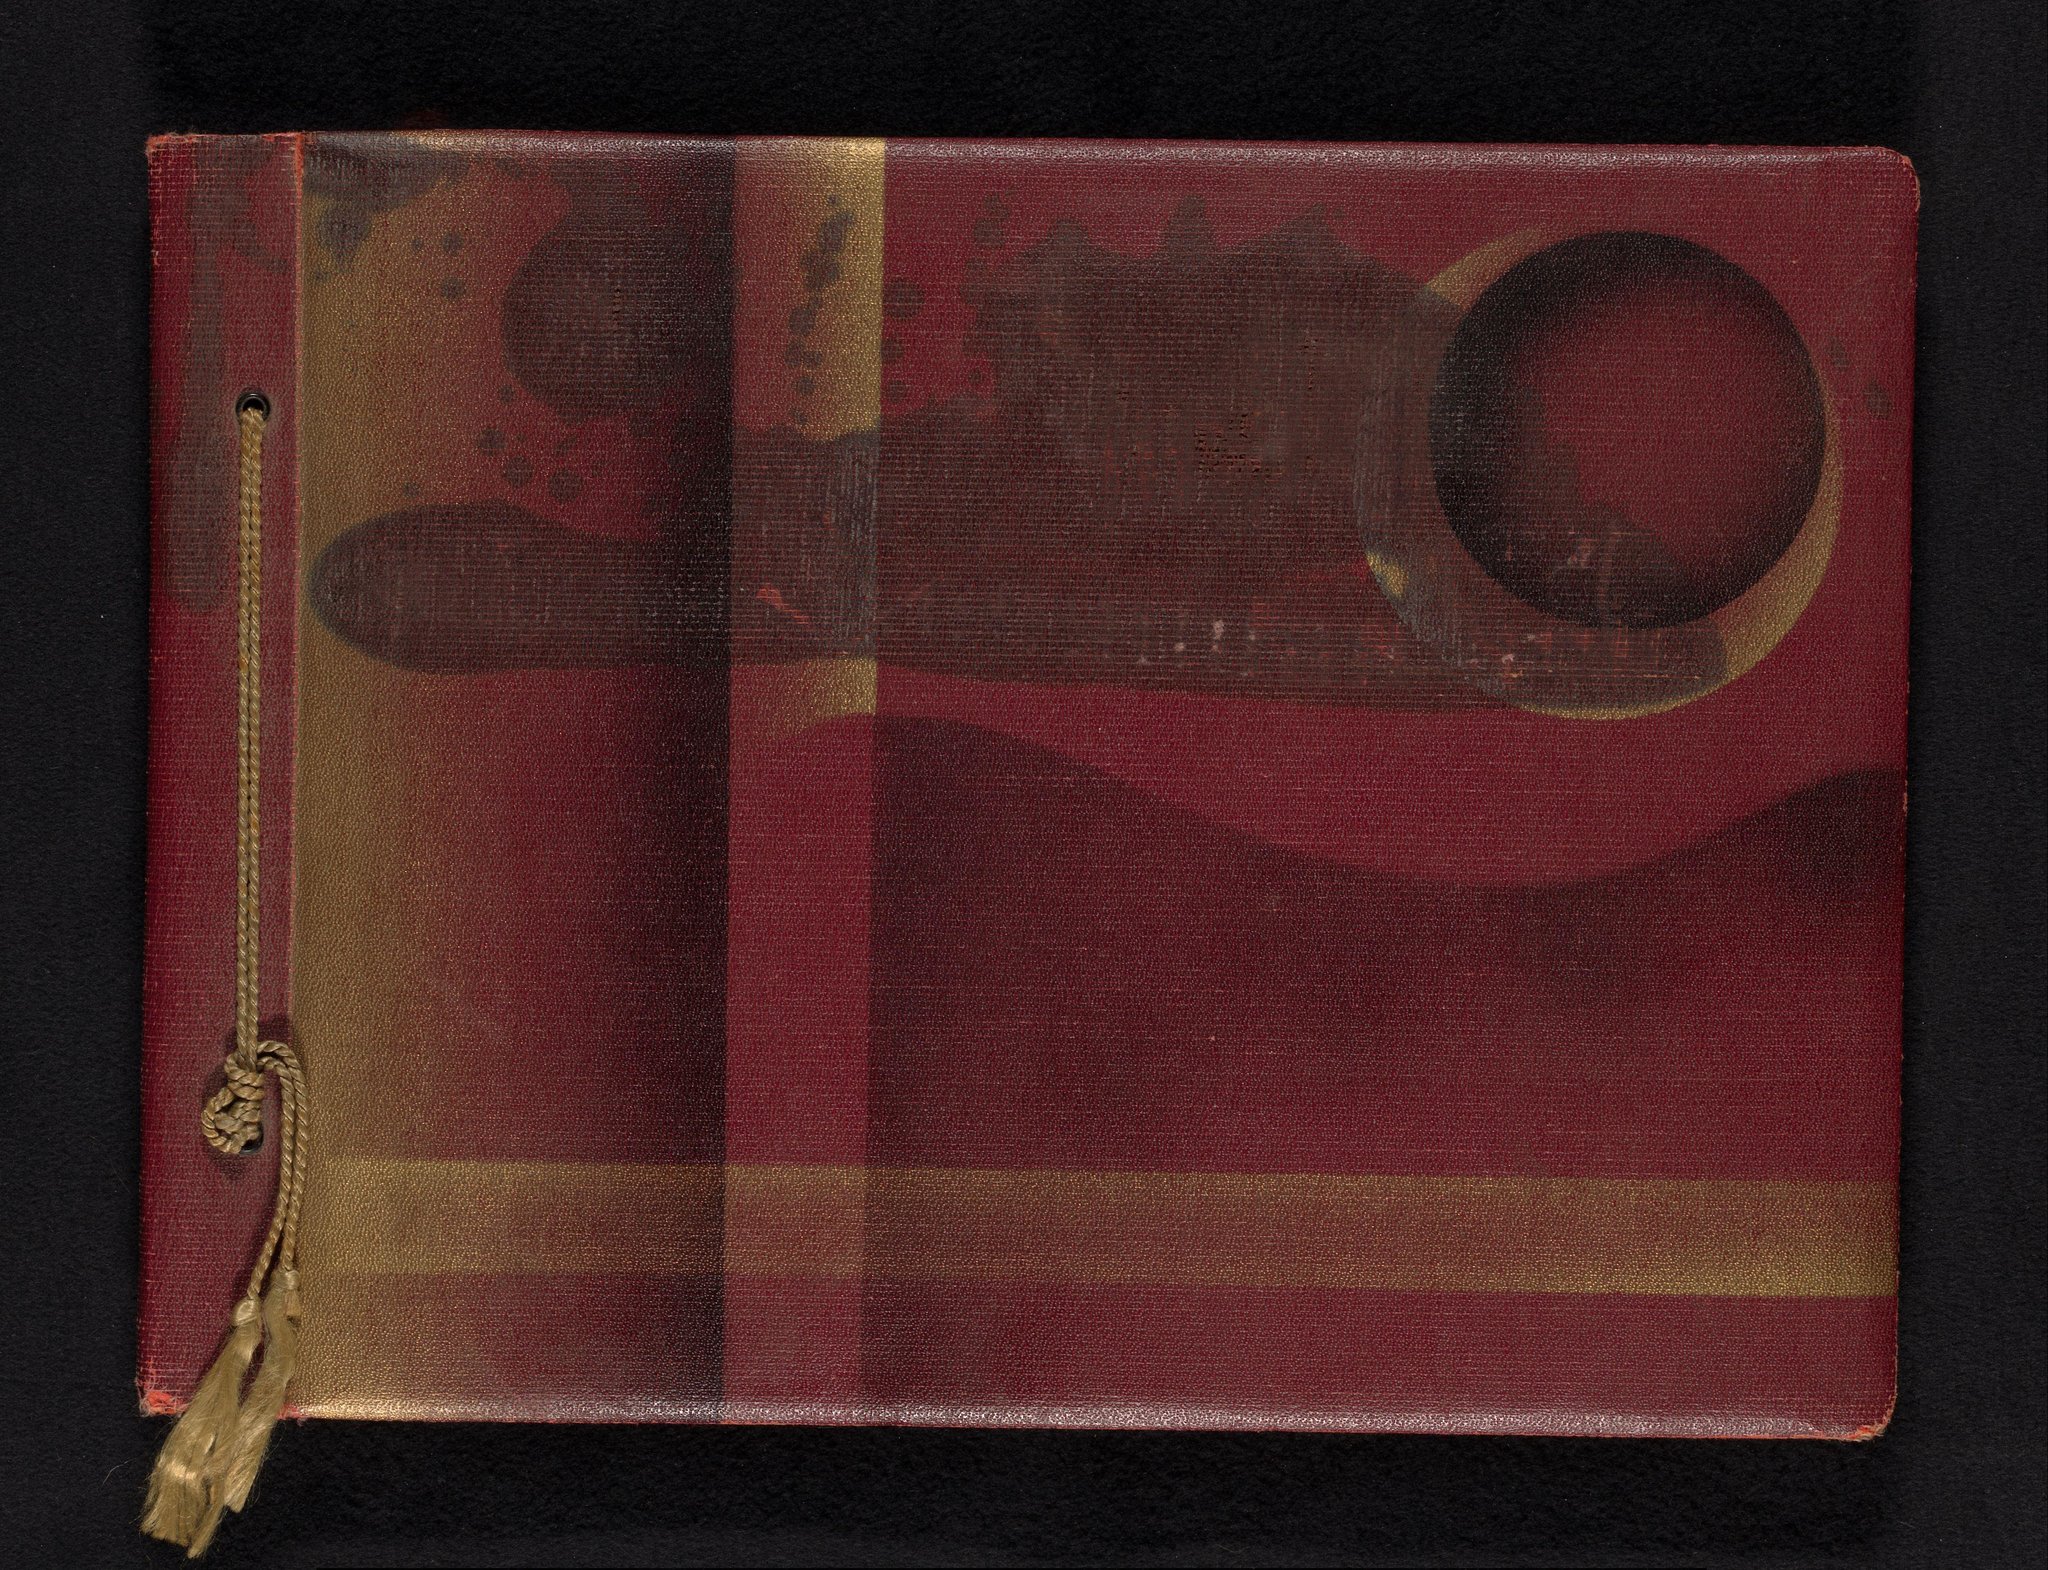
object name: photograph album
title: Fotoalbum Nederlands-Indië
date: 1950-1960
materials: cardboard, paper, photographic support, textile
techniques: gelatin silver print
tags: ritual practices ~ non-christian religions, ritual music and dancing ~ non-christian religions, child, historical persons, funerary ceremonial, temple, shrine ~ non-christian religions, indonesia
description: Fotoalbum met 50 pagina's met 61 foto's van Nederlands-Indië.